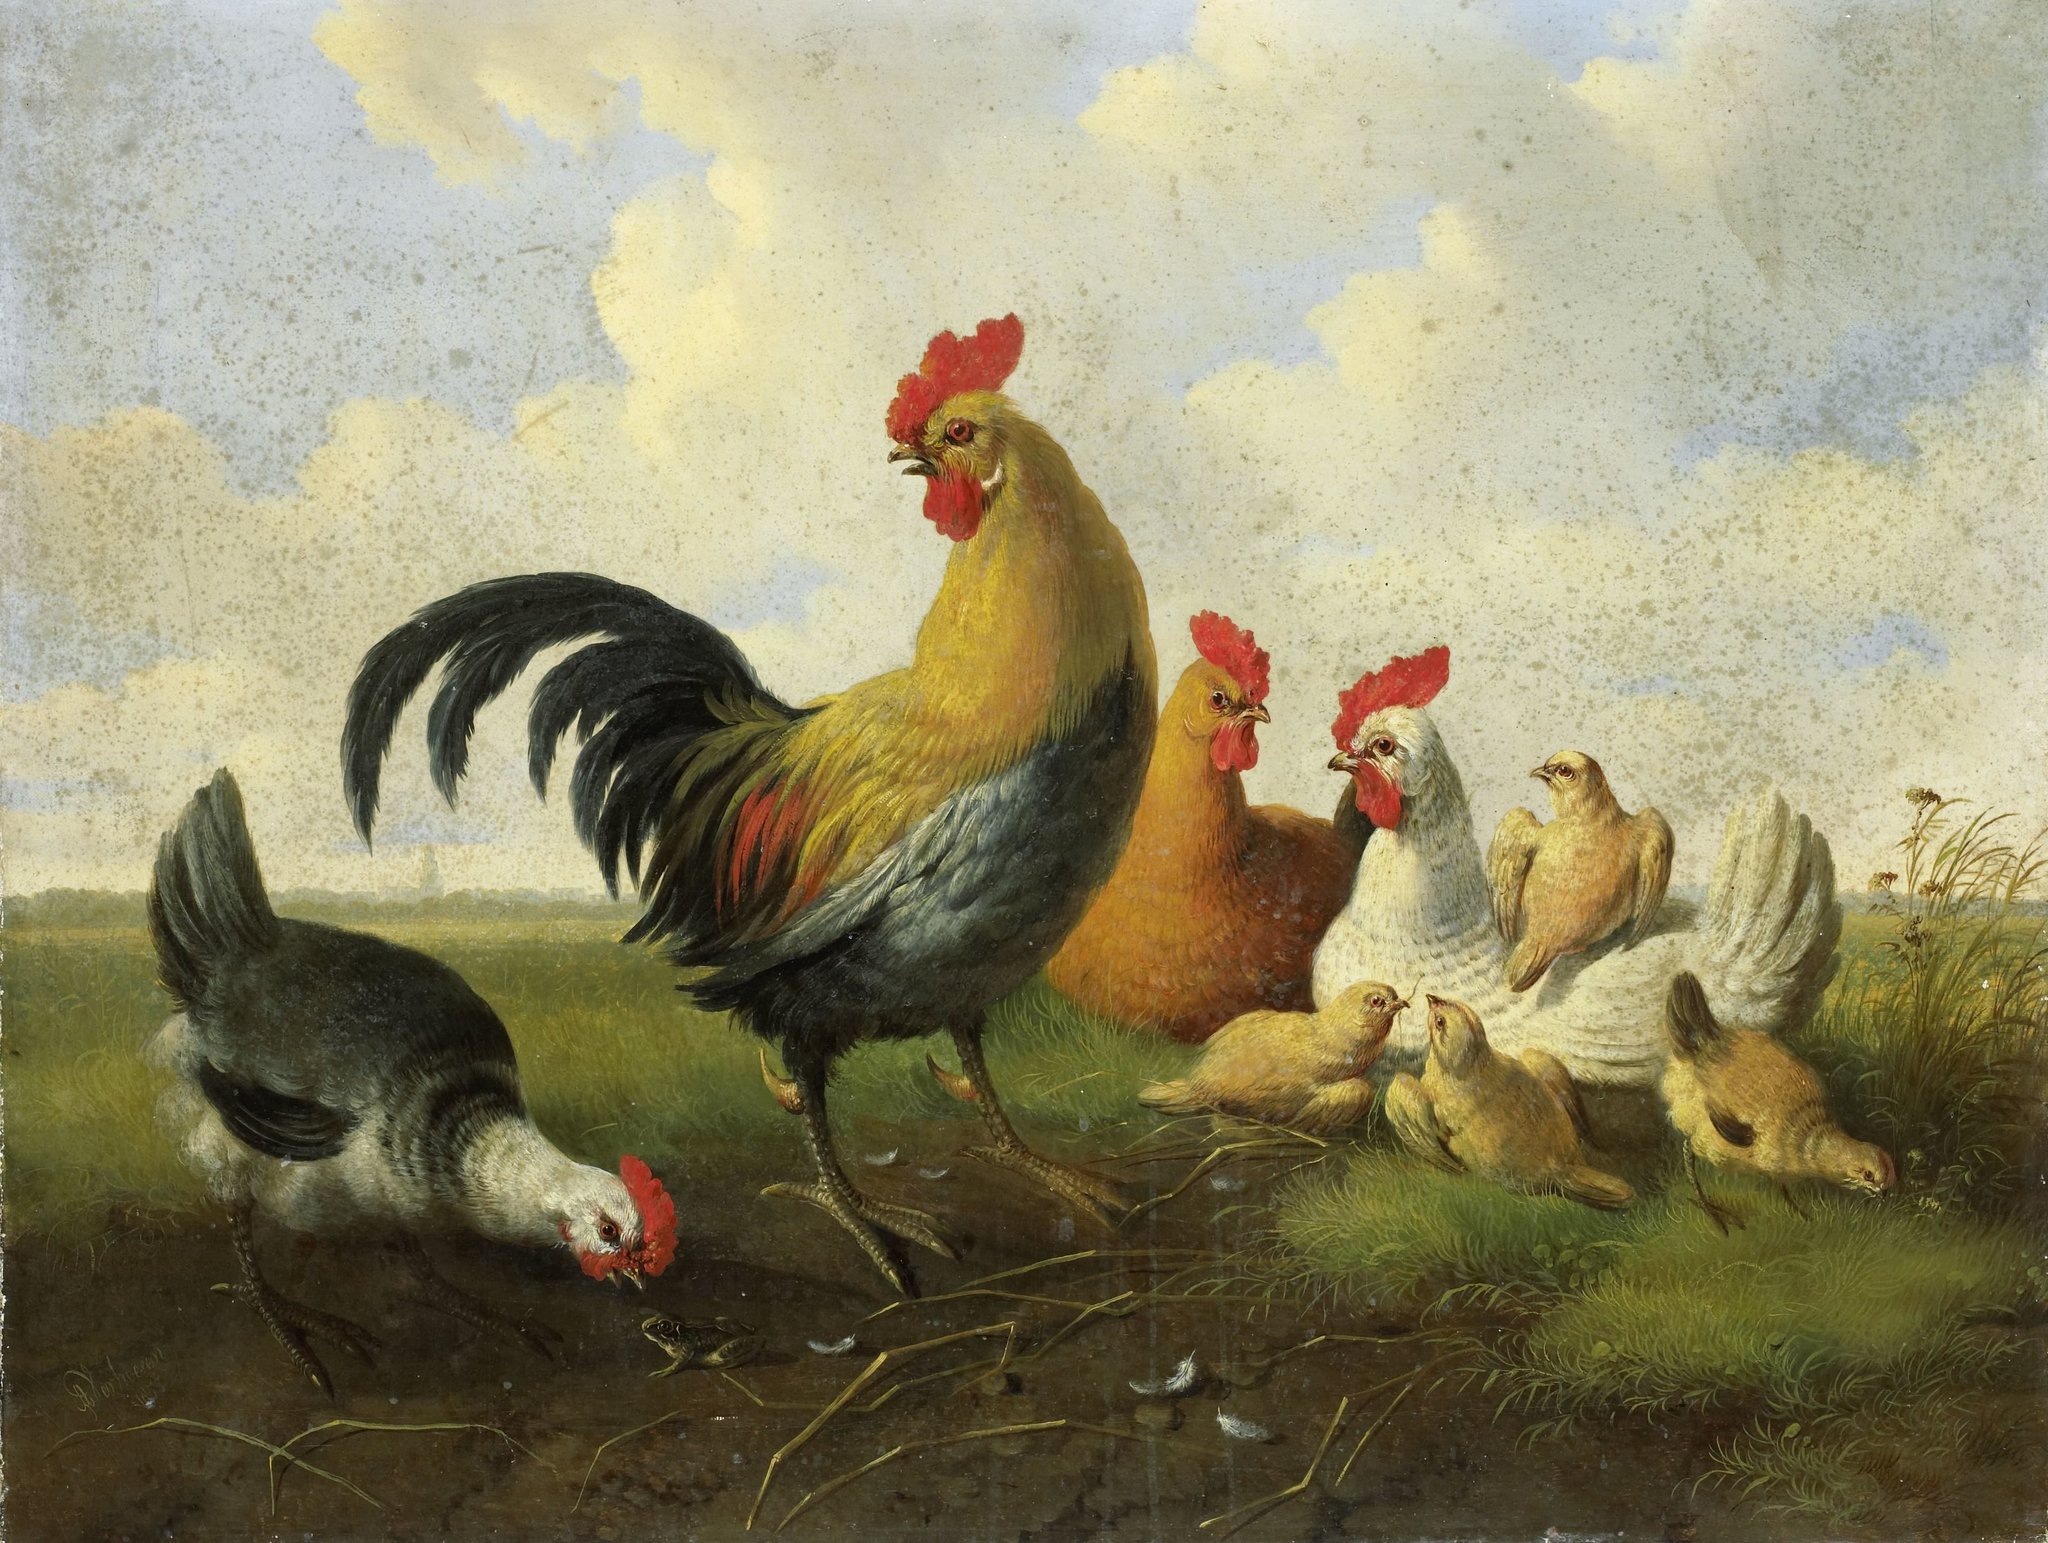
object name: painting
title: A rooster with Hens and Chicks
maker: albertus verhoesen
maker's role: draughtsman, painter, print maker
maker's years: 1806-1881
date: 1855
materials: canvas, oil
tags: fowl (cock, hen, chicken, etc.)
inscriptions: signature and date: ‘A. Verhoesen 1855’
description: Kippen: een haan met hennen en kuikens in het gras. De hen links kijkt naar een kikker.